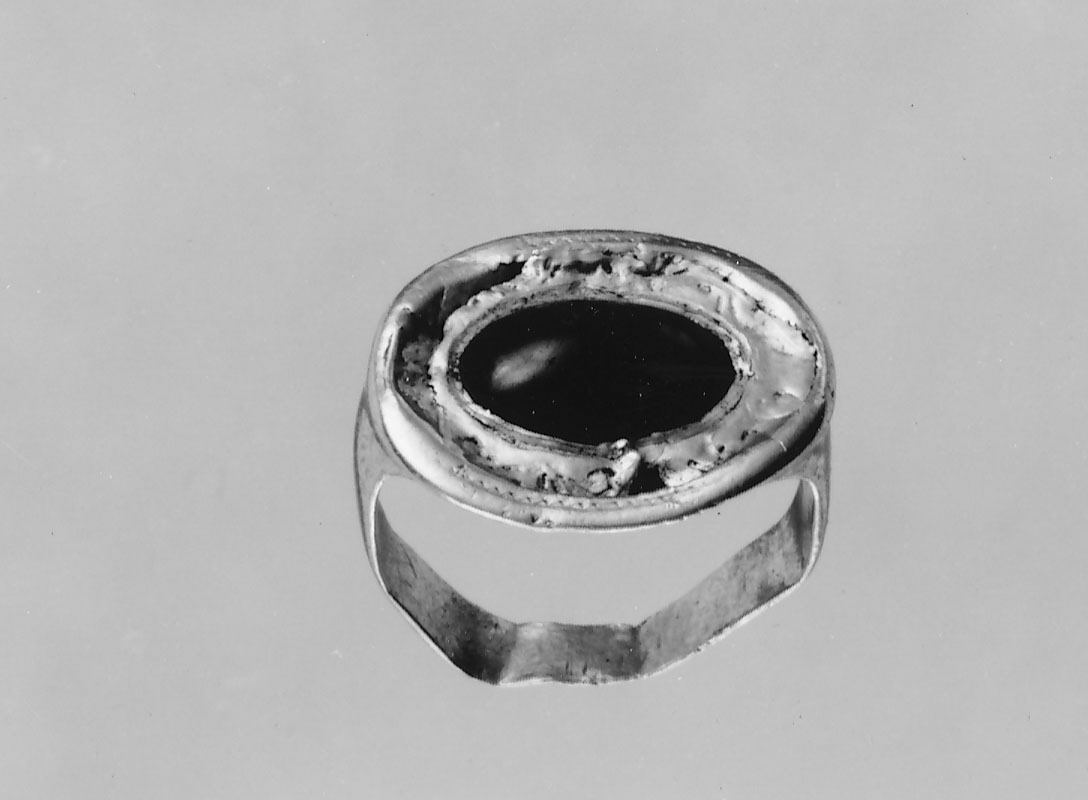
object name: ring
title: Gold ring with a garnet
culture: greek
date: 300-250 BCE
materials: bone, gemstone, gold